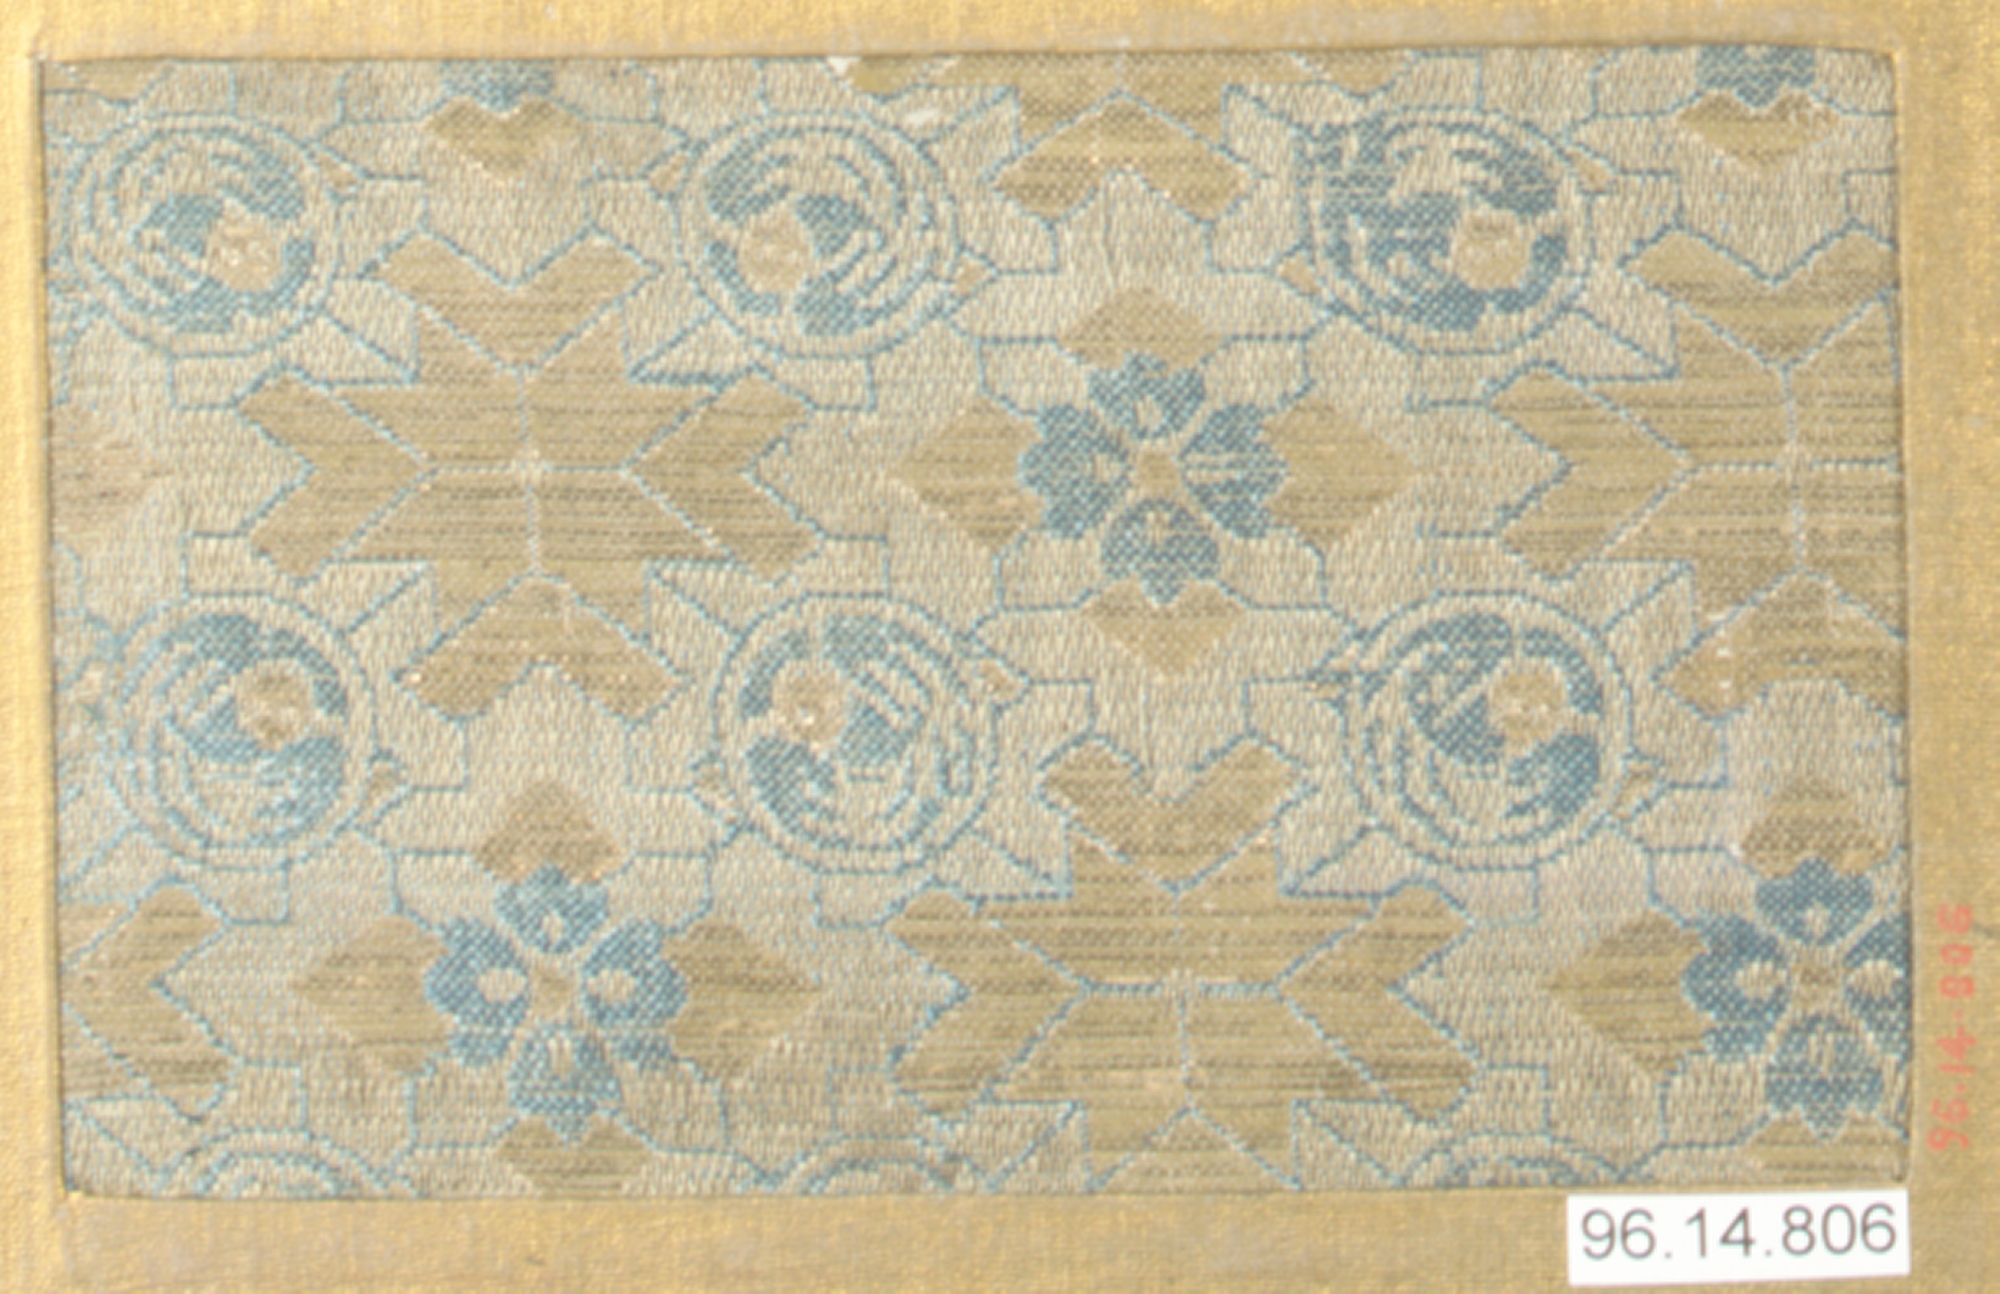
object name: piece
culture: japanese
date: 1701-1900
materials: silk